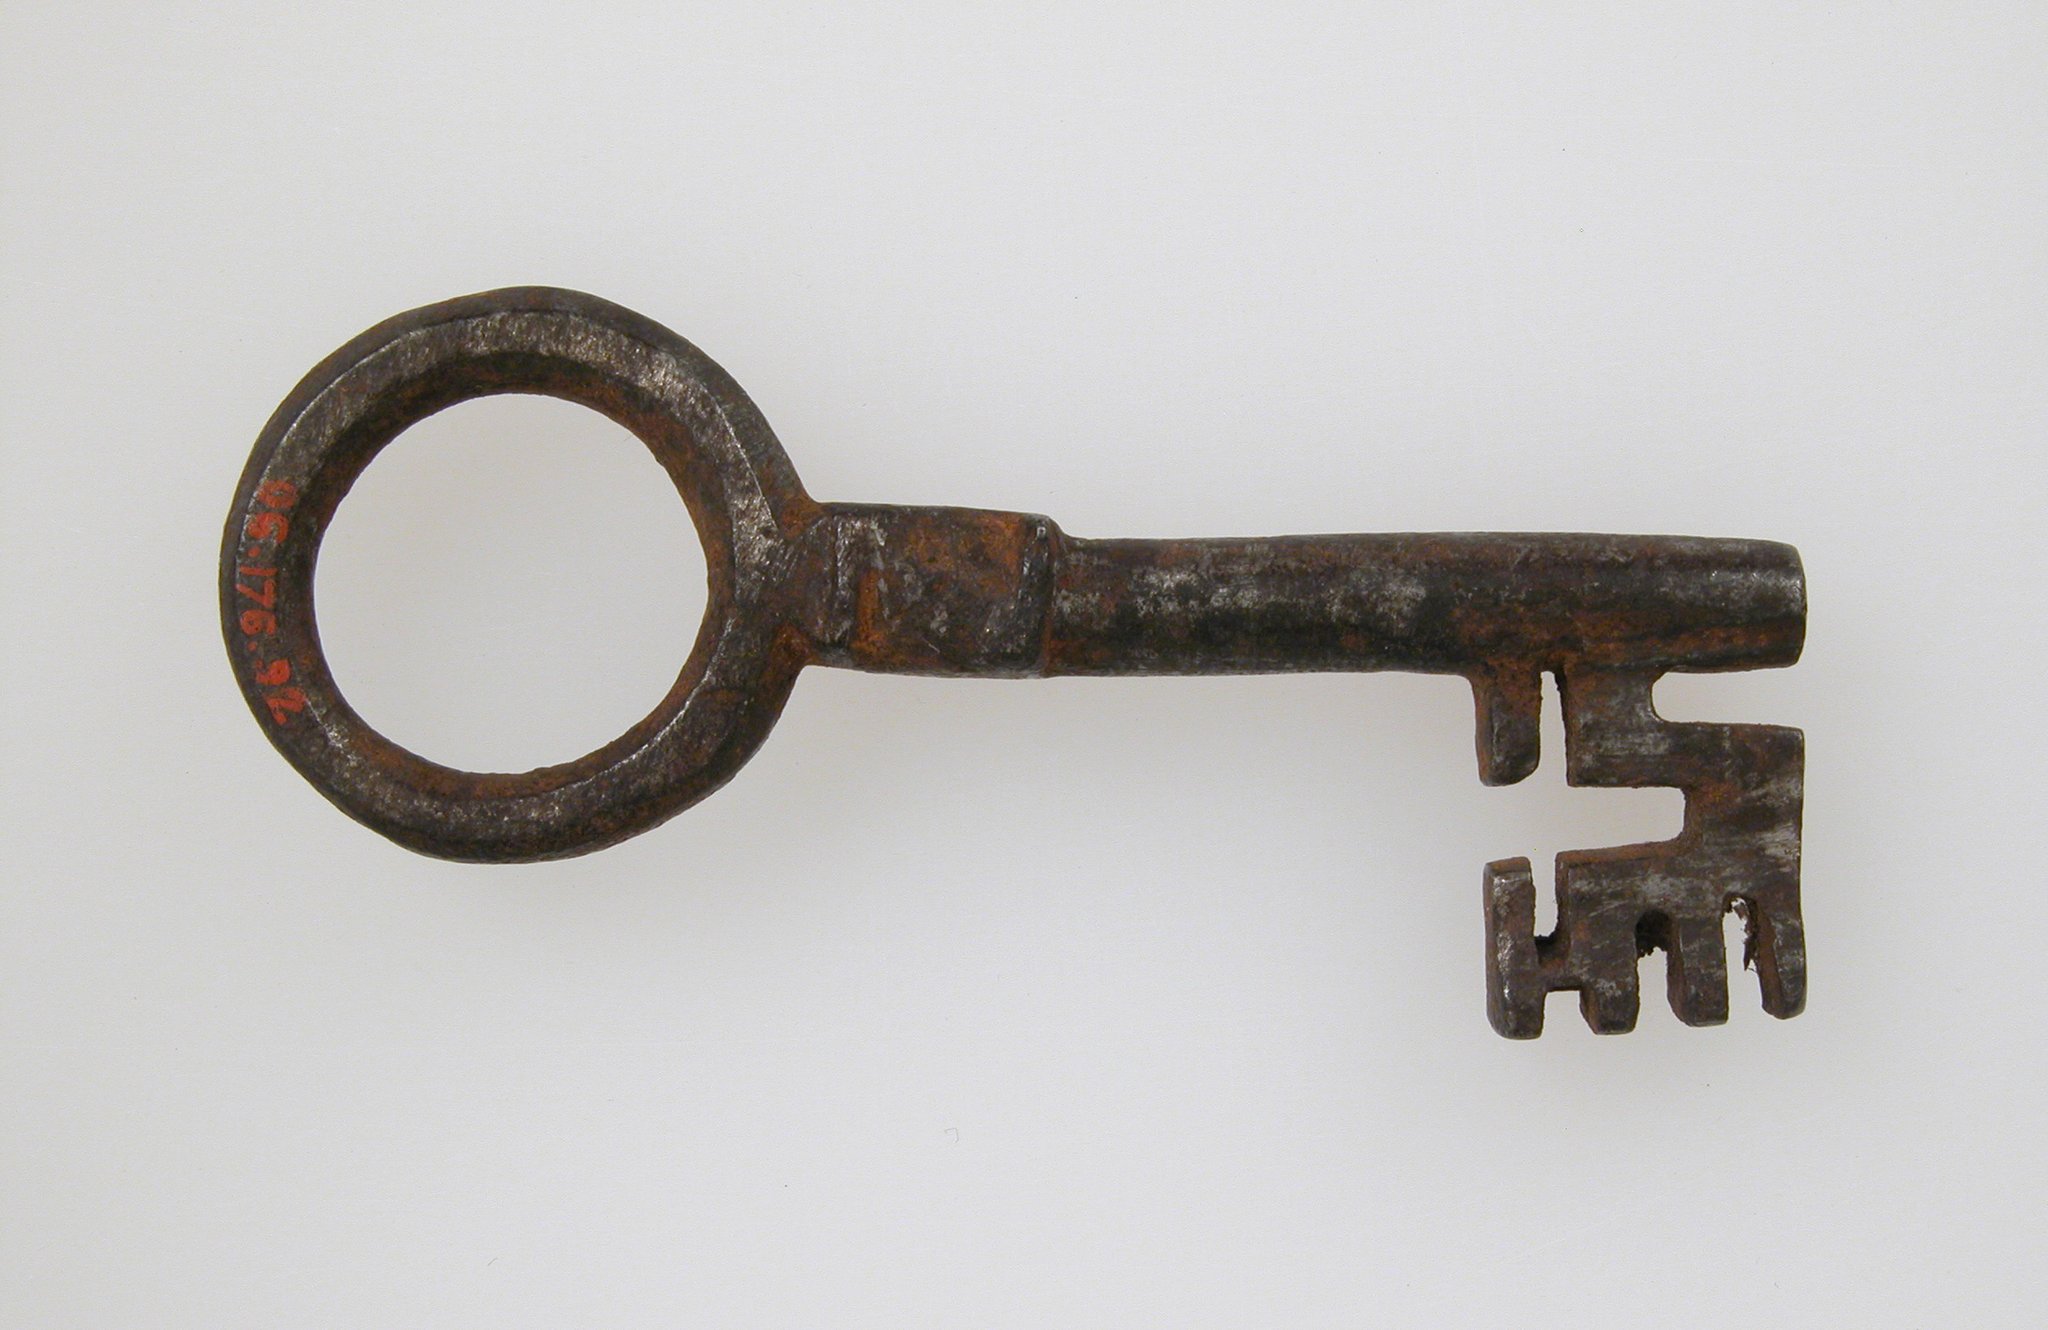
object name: key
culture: french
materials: iron